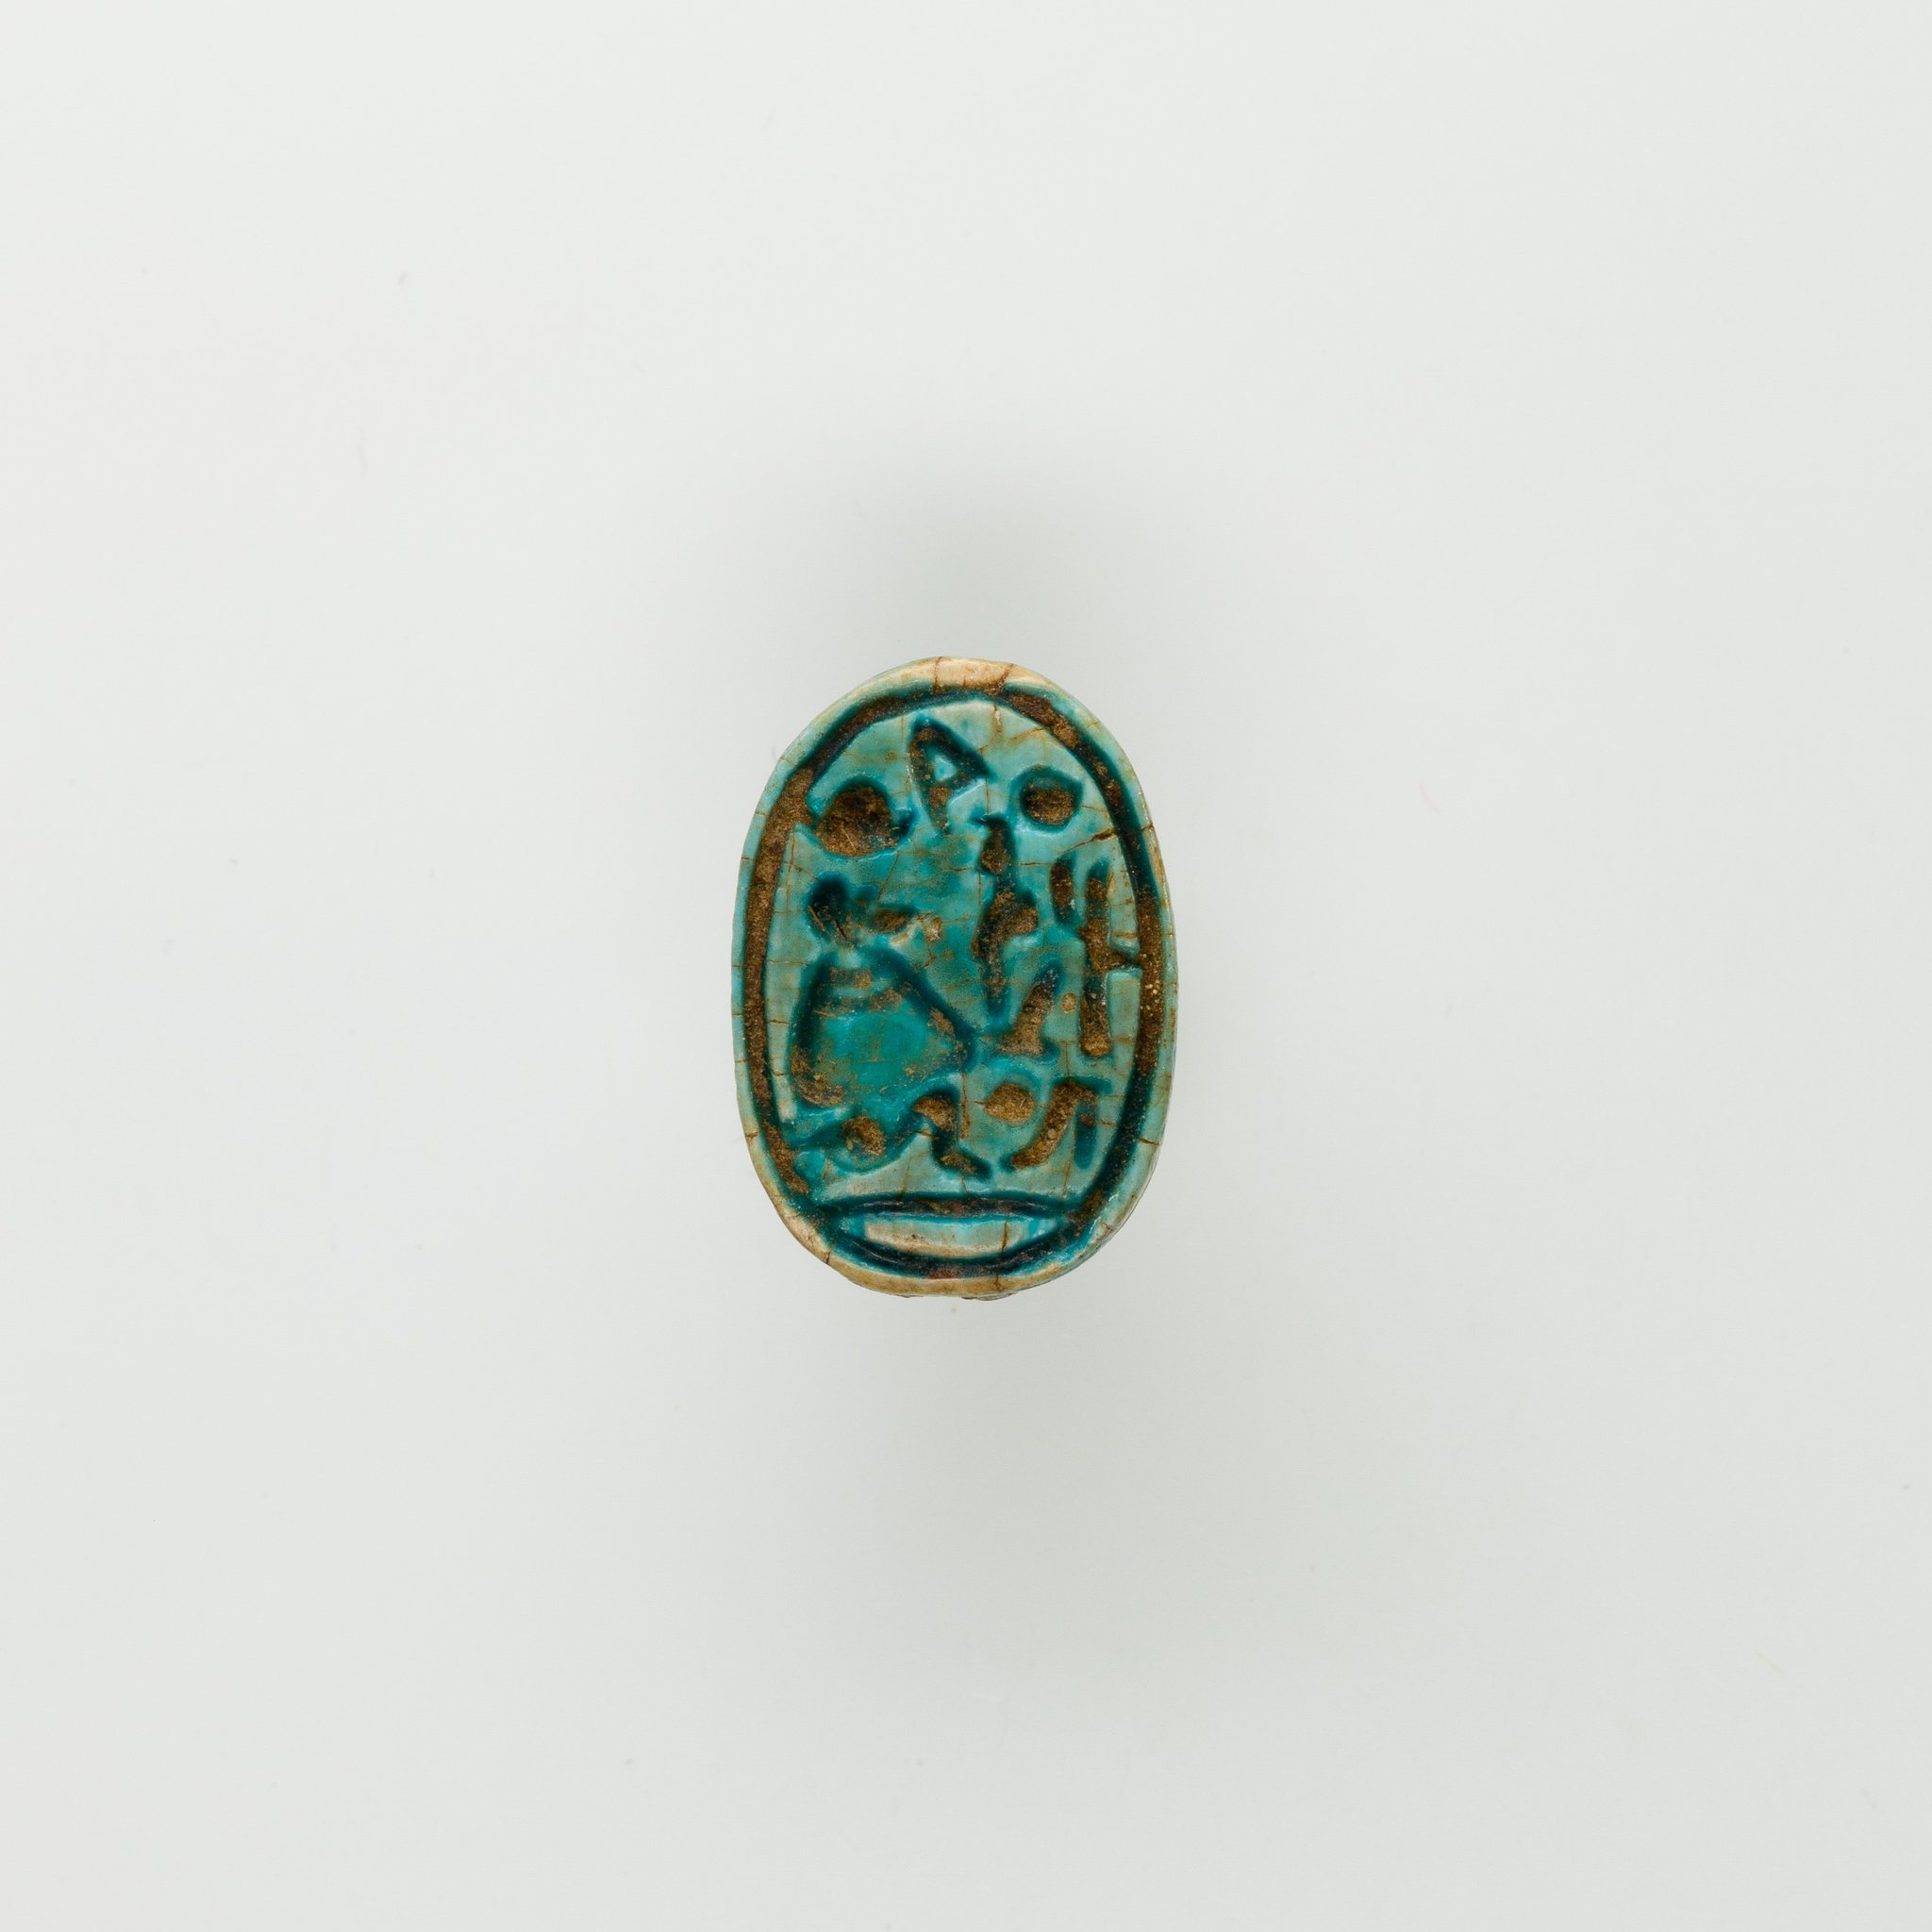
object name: scarab, ramesses ii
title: Scarab of Ramesses II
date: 1295-1070 BCE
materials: stone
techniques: glazing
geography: egypt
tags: scarabs